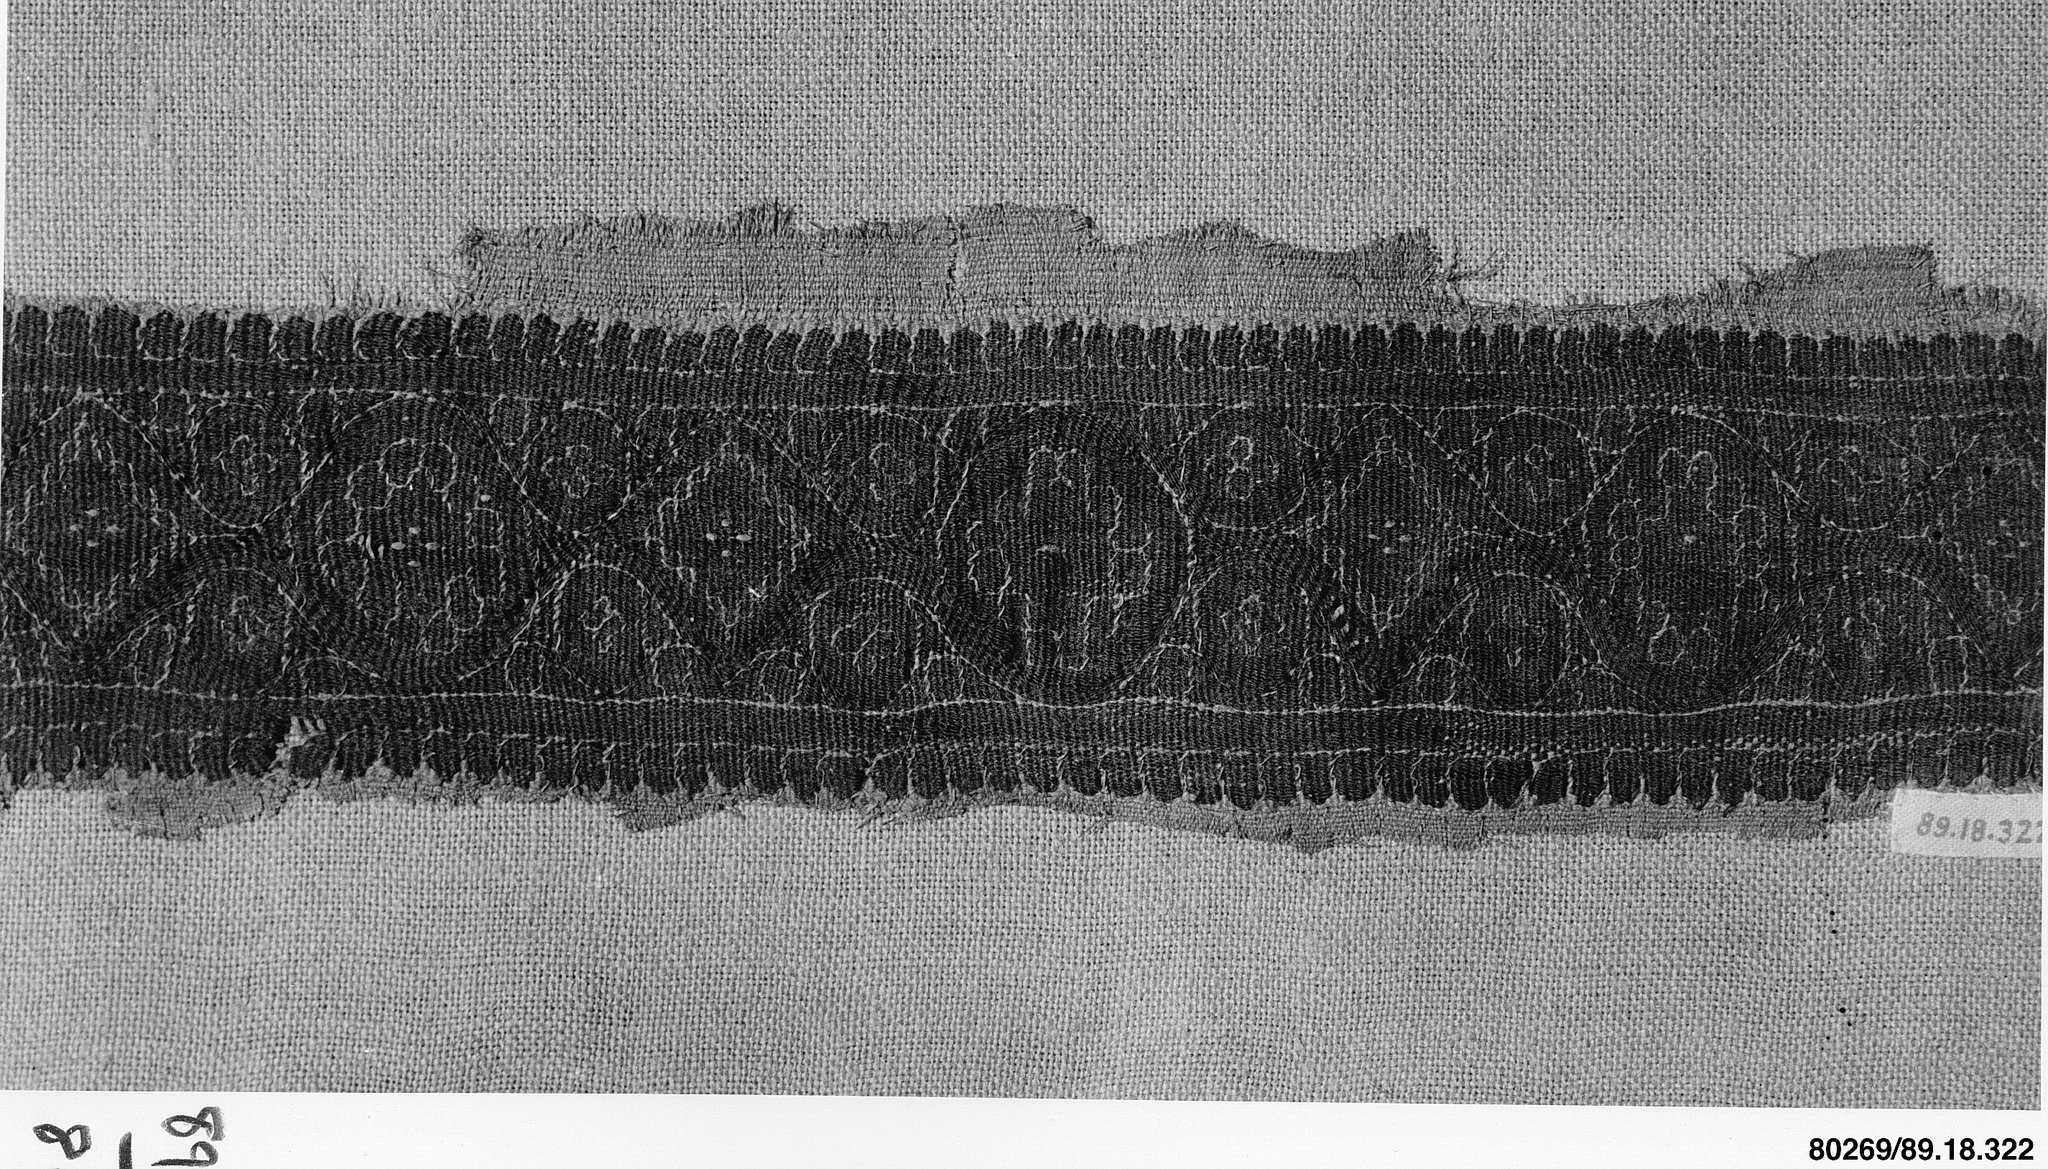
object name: textile fragment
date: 201-400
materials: linen, wool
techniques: weave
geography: egypt